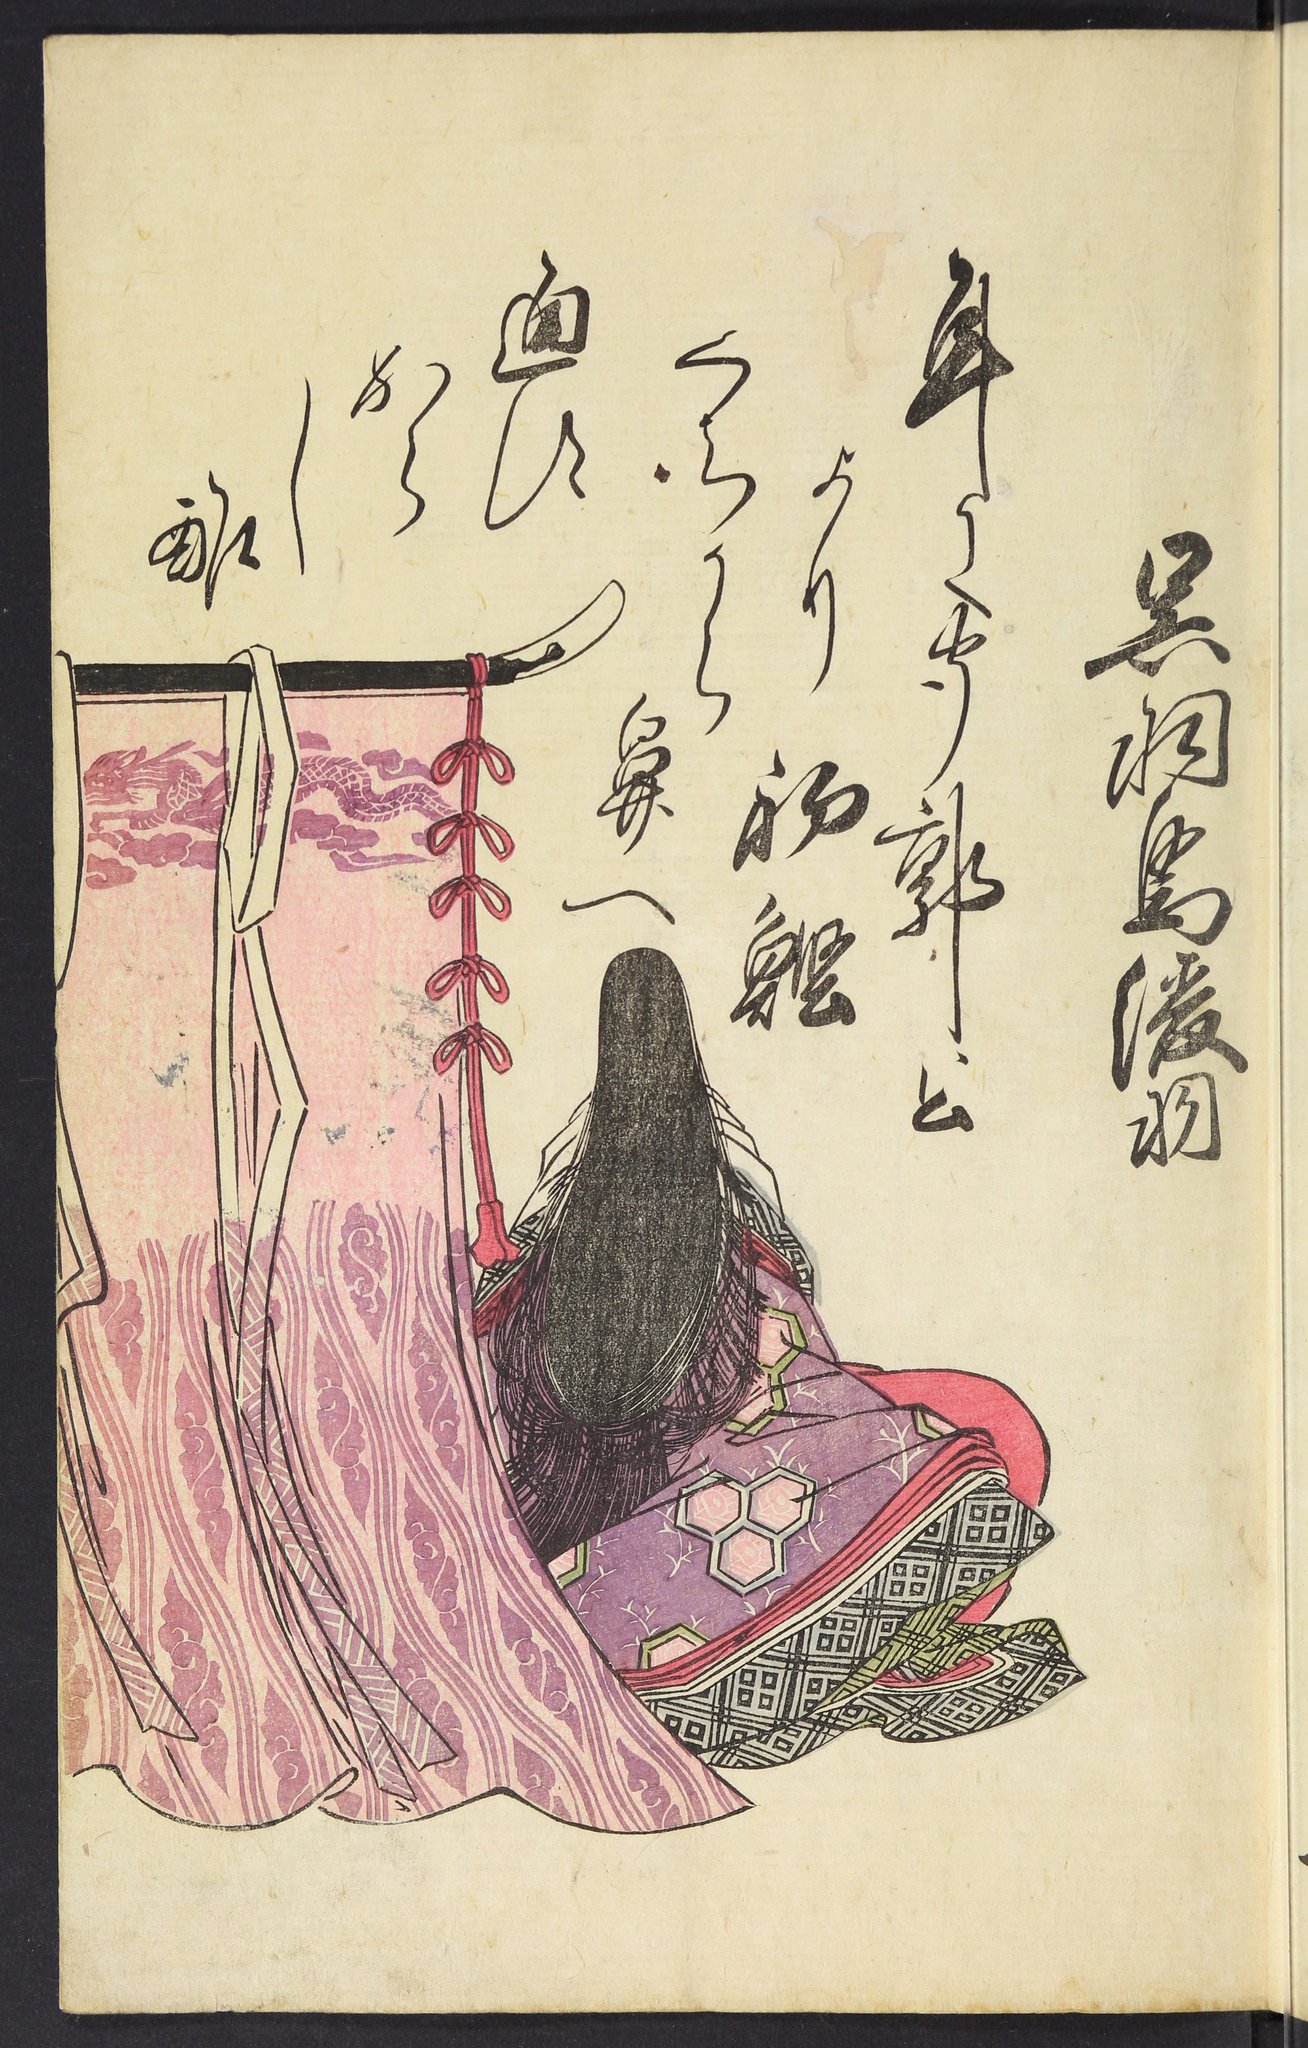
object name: illustrated book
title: A Collection of Witty Poems on Michinoku Paper (Michinoku-gami kyōka awase) 陸奥紙狂歌合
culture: japanese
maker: utagawa toyohiro (ichiryūsai) 歌川 (一柳斎) 豊広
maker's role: artist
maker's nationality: japanese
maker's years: 1763-1828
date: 1793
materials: ink, paper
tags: poetry,women,curtains